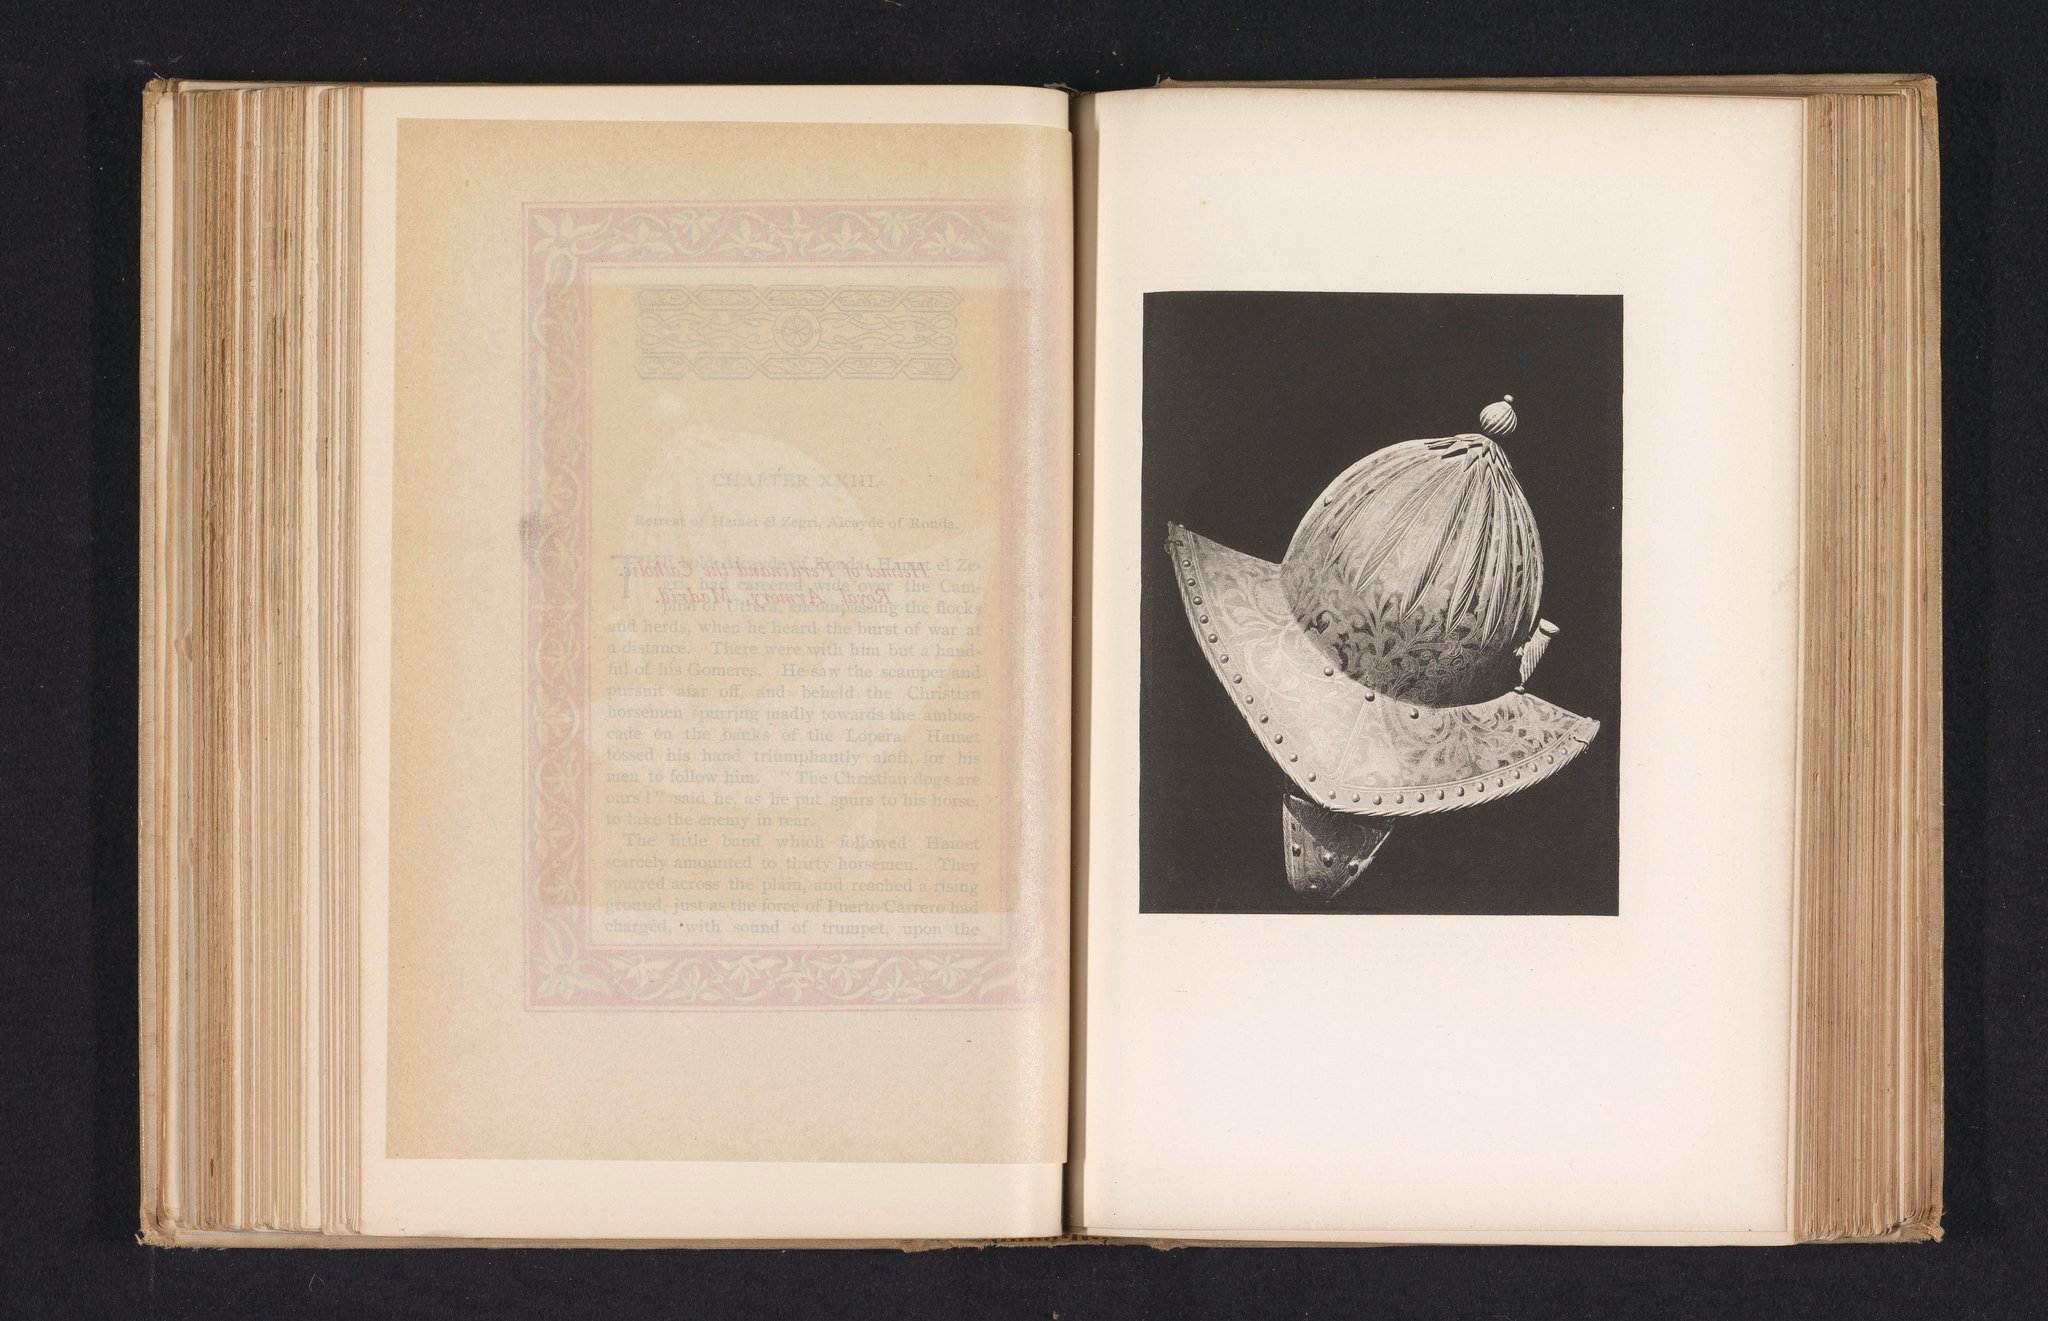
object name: page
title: Helmet of Ferdinand the Catholic. Royal Armory. Madrid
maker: Anonymous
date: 1883-1893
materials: paper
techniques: photoaquatint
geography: madrid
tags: helmet